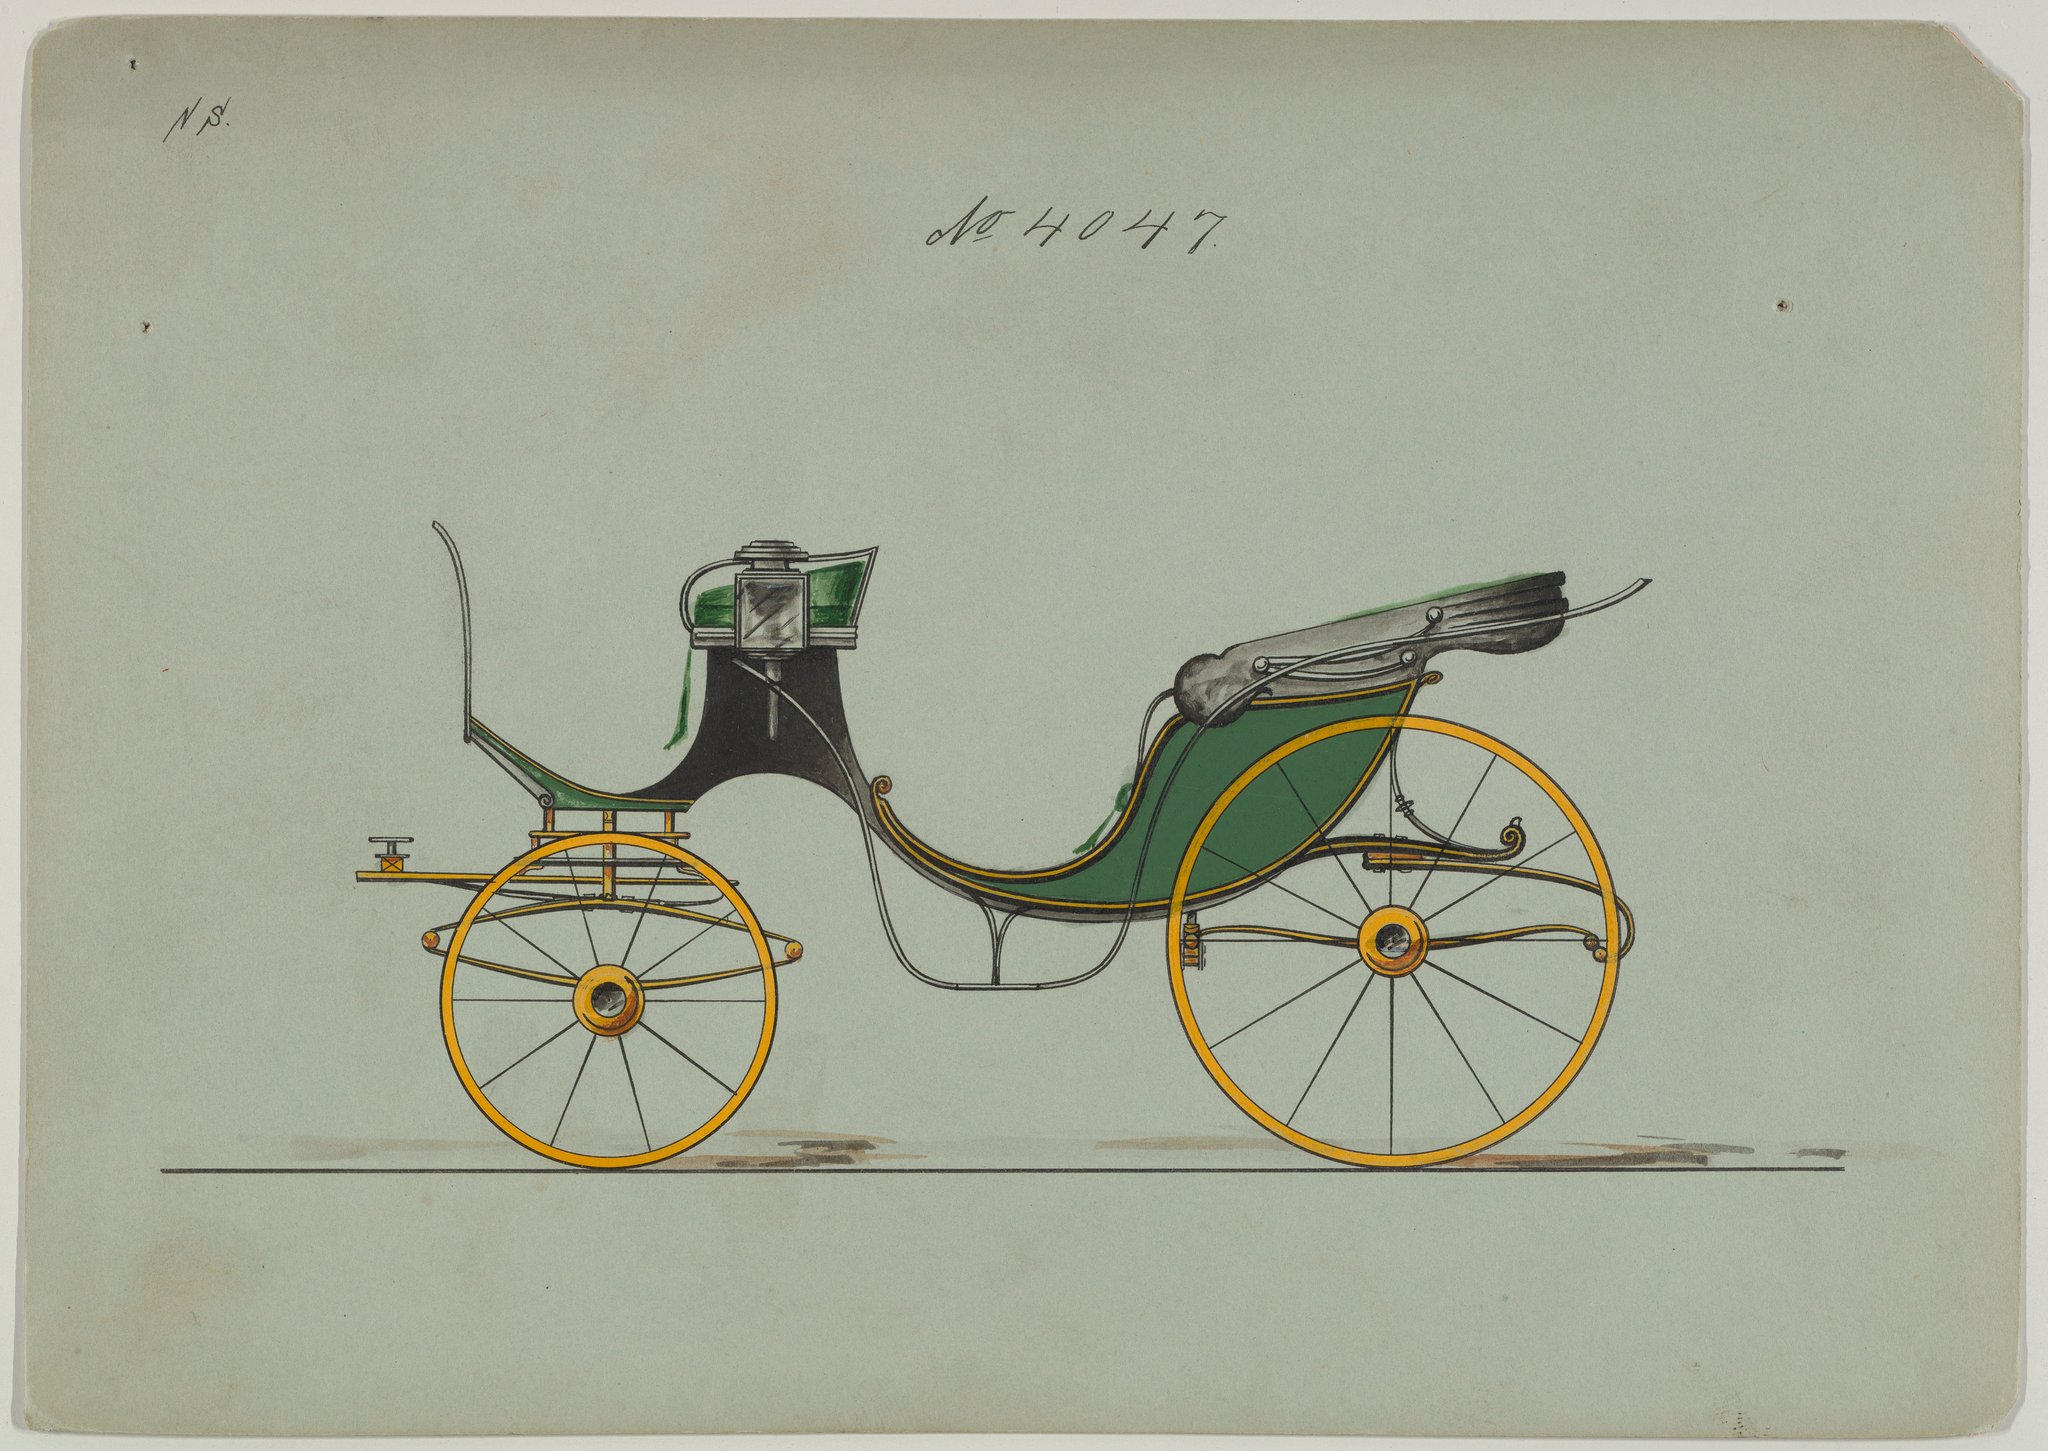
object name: drawing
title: Design for Cabriolet or Victoria, no. 4049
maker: brewster & co.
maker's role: manufacturer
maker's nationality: american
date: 1889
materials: gouache, ink, watercolor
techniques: pen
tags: carriages